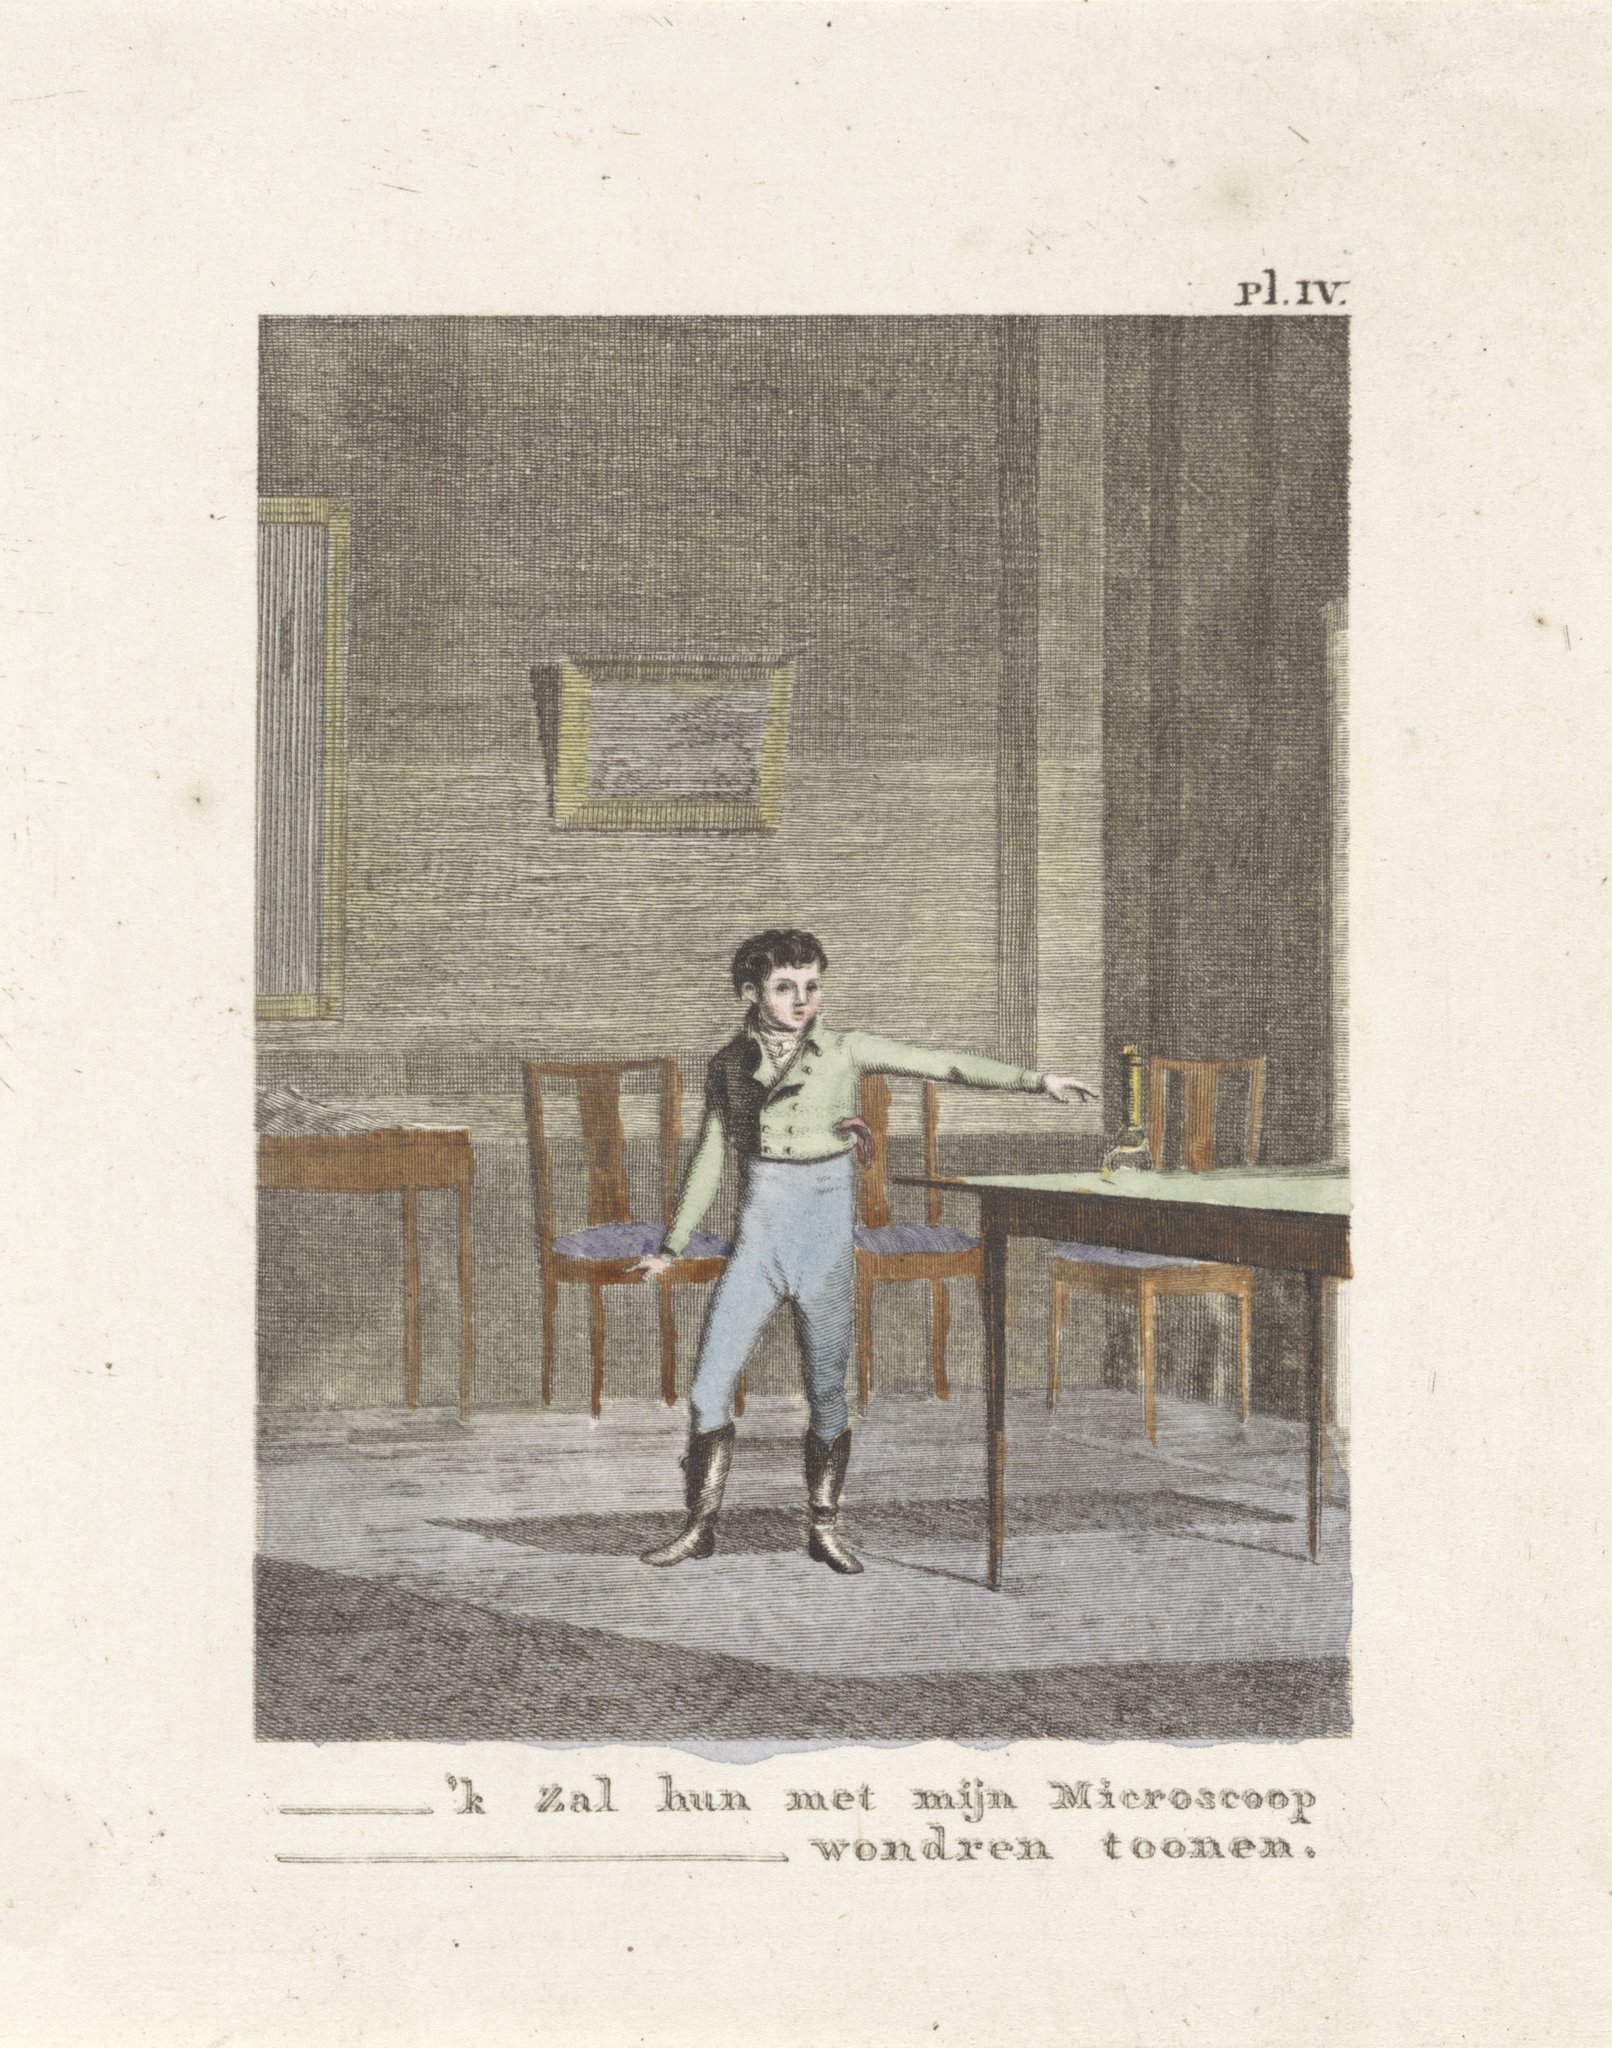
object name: book illustration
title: Jongen wijst naar een microscoop op een tafel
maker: izaak jansz. de wit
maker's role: draughtsman, print maker, publisher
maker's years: 1744-1809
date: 1806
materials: paper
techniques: etching, hand coloring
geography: haarlem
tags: table, child (at home), microscope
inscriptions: collector's mark: Lugt 2228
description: Prent gebruikt in: Moens, Petronella. Letter-kransje voor lieve en brave kinderen. Haarlem: Adriaan Pietrsz. Loosjes, 1806.